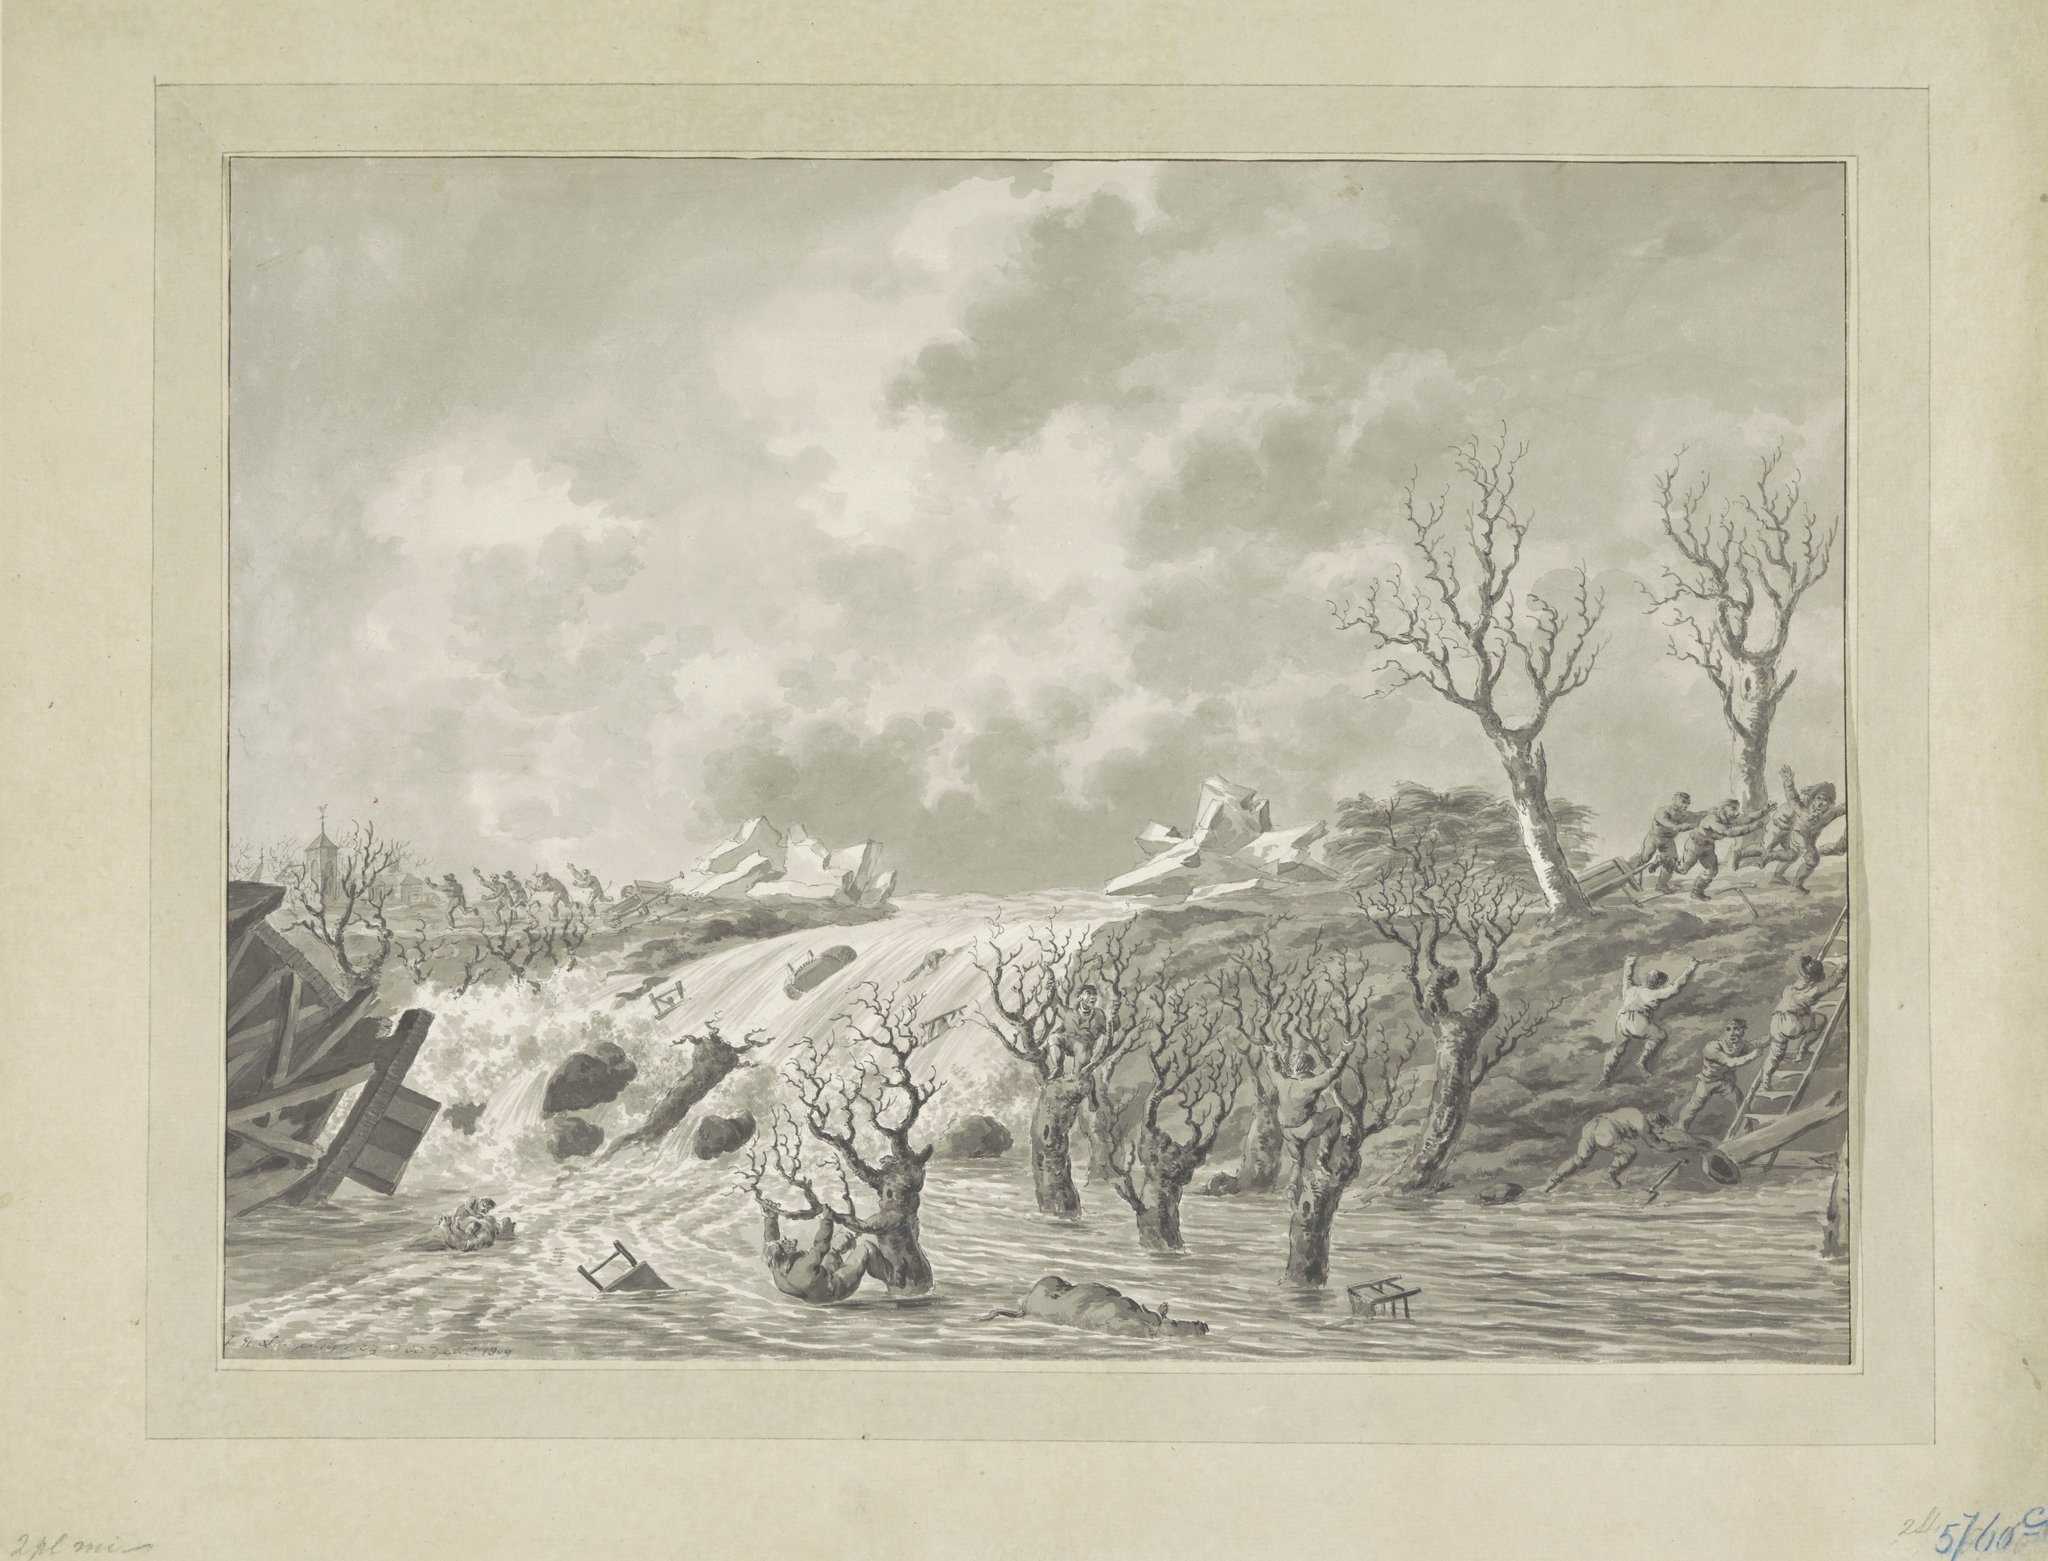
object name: print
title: Dijkdoorbraak bij Kedichem, 1809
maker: jan anthonie langendijk dzn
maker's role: draughtsman, print maker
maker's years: 1780-1818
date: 1809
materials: paper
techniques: brush, pen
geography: netherlands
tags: dike-break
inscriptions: signature and date: ‘J.A. Langendijk Dz ad viv delin 1809’, collector's mark: Lugt 2228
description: Doorbraak van de Lingedijk bij Kedichem tijdens de watersnood op 30 januari 1809. Verschillende personen klimmen in bomen om aan het water te ontkomen, links en rechts van de doorgebroken dijk vluchten groepen personen. Met pendant.